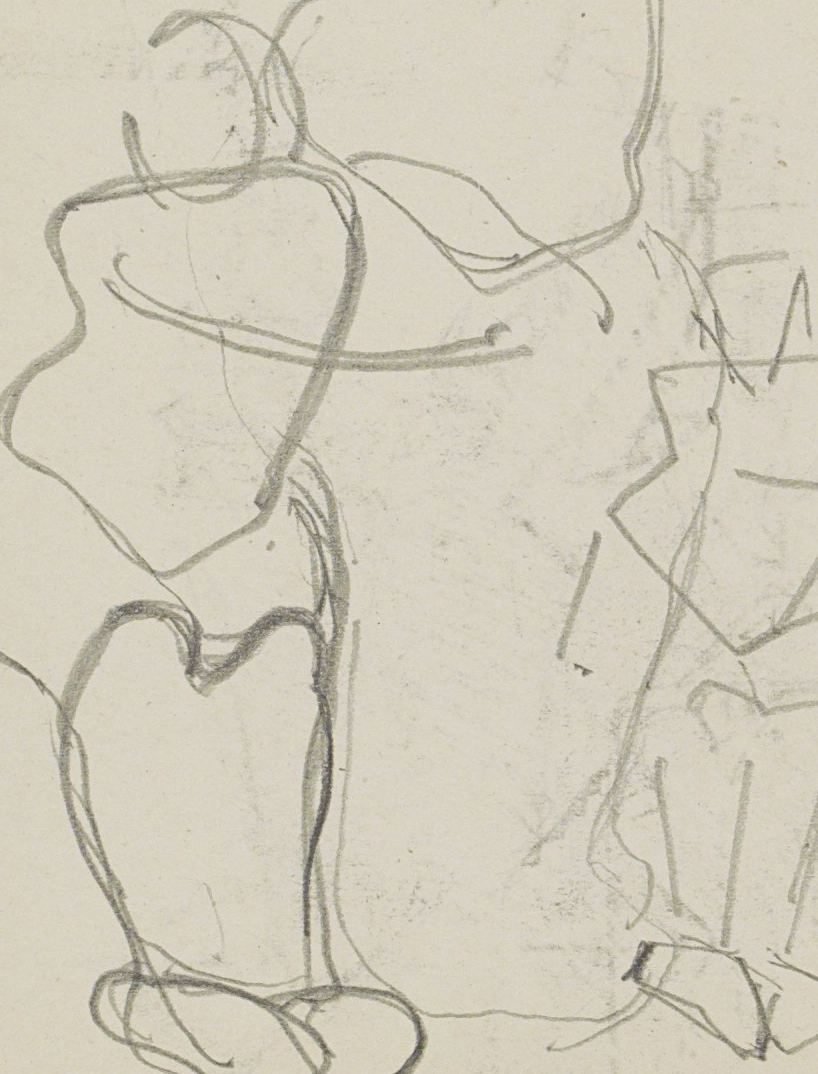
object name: sketchbook leaf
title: Staande figuren met gebogen knieën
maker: reijer stolk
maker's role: draughtsman, print maker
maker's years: 1896-1945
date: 1906-1945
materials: paper, pencil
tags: standing figure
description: Blad 42 verso uit een schetsboek met 53 bladen.